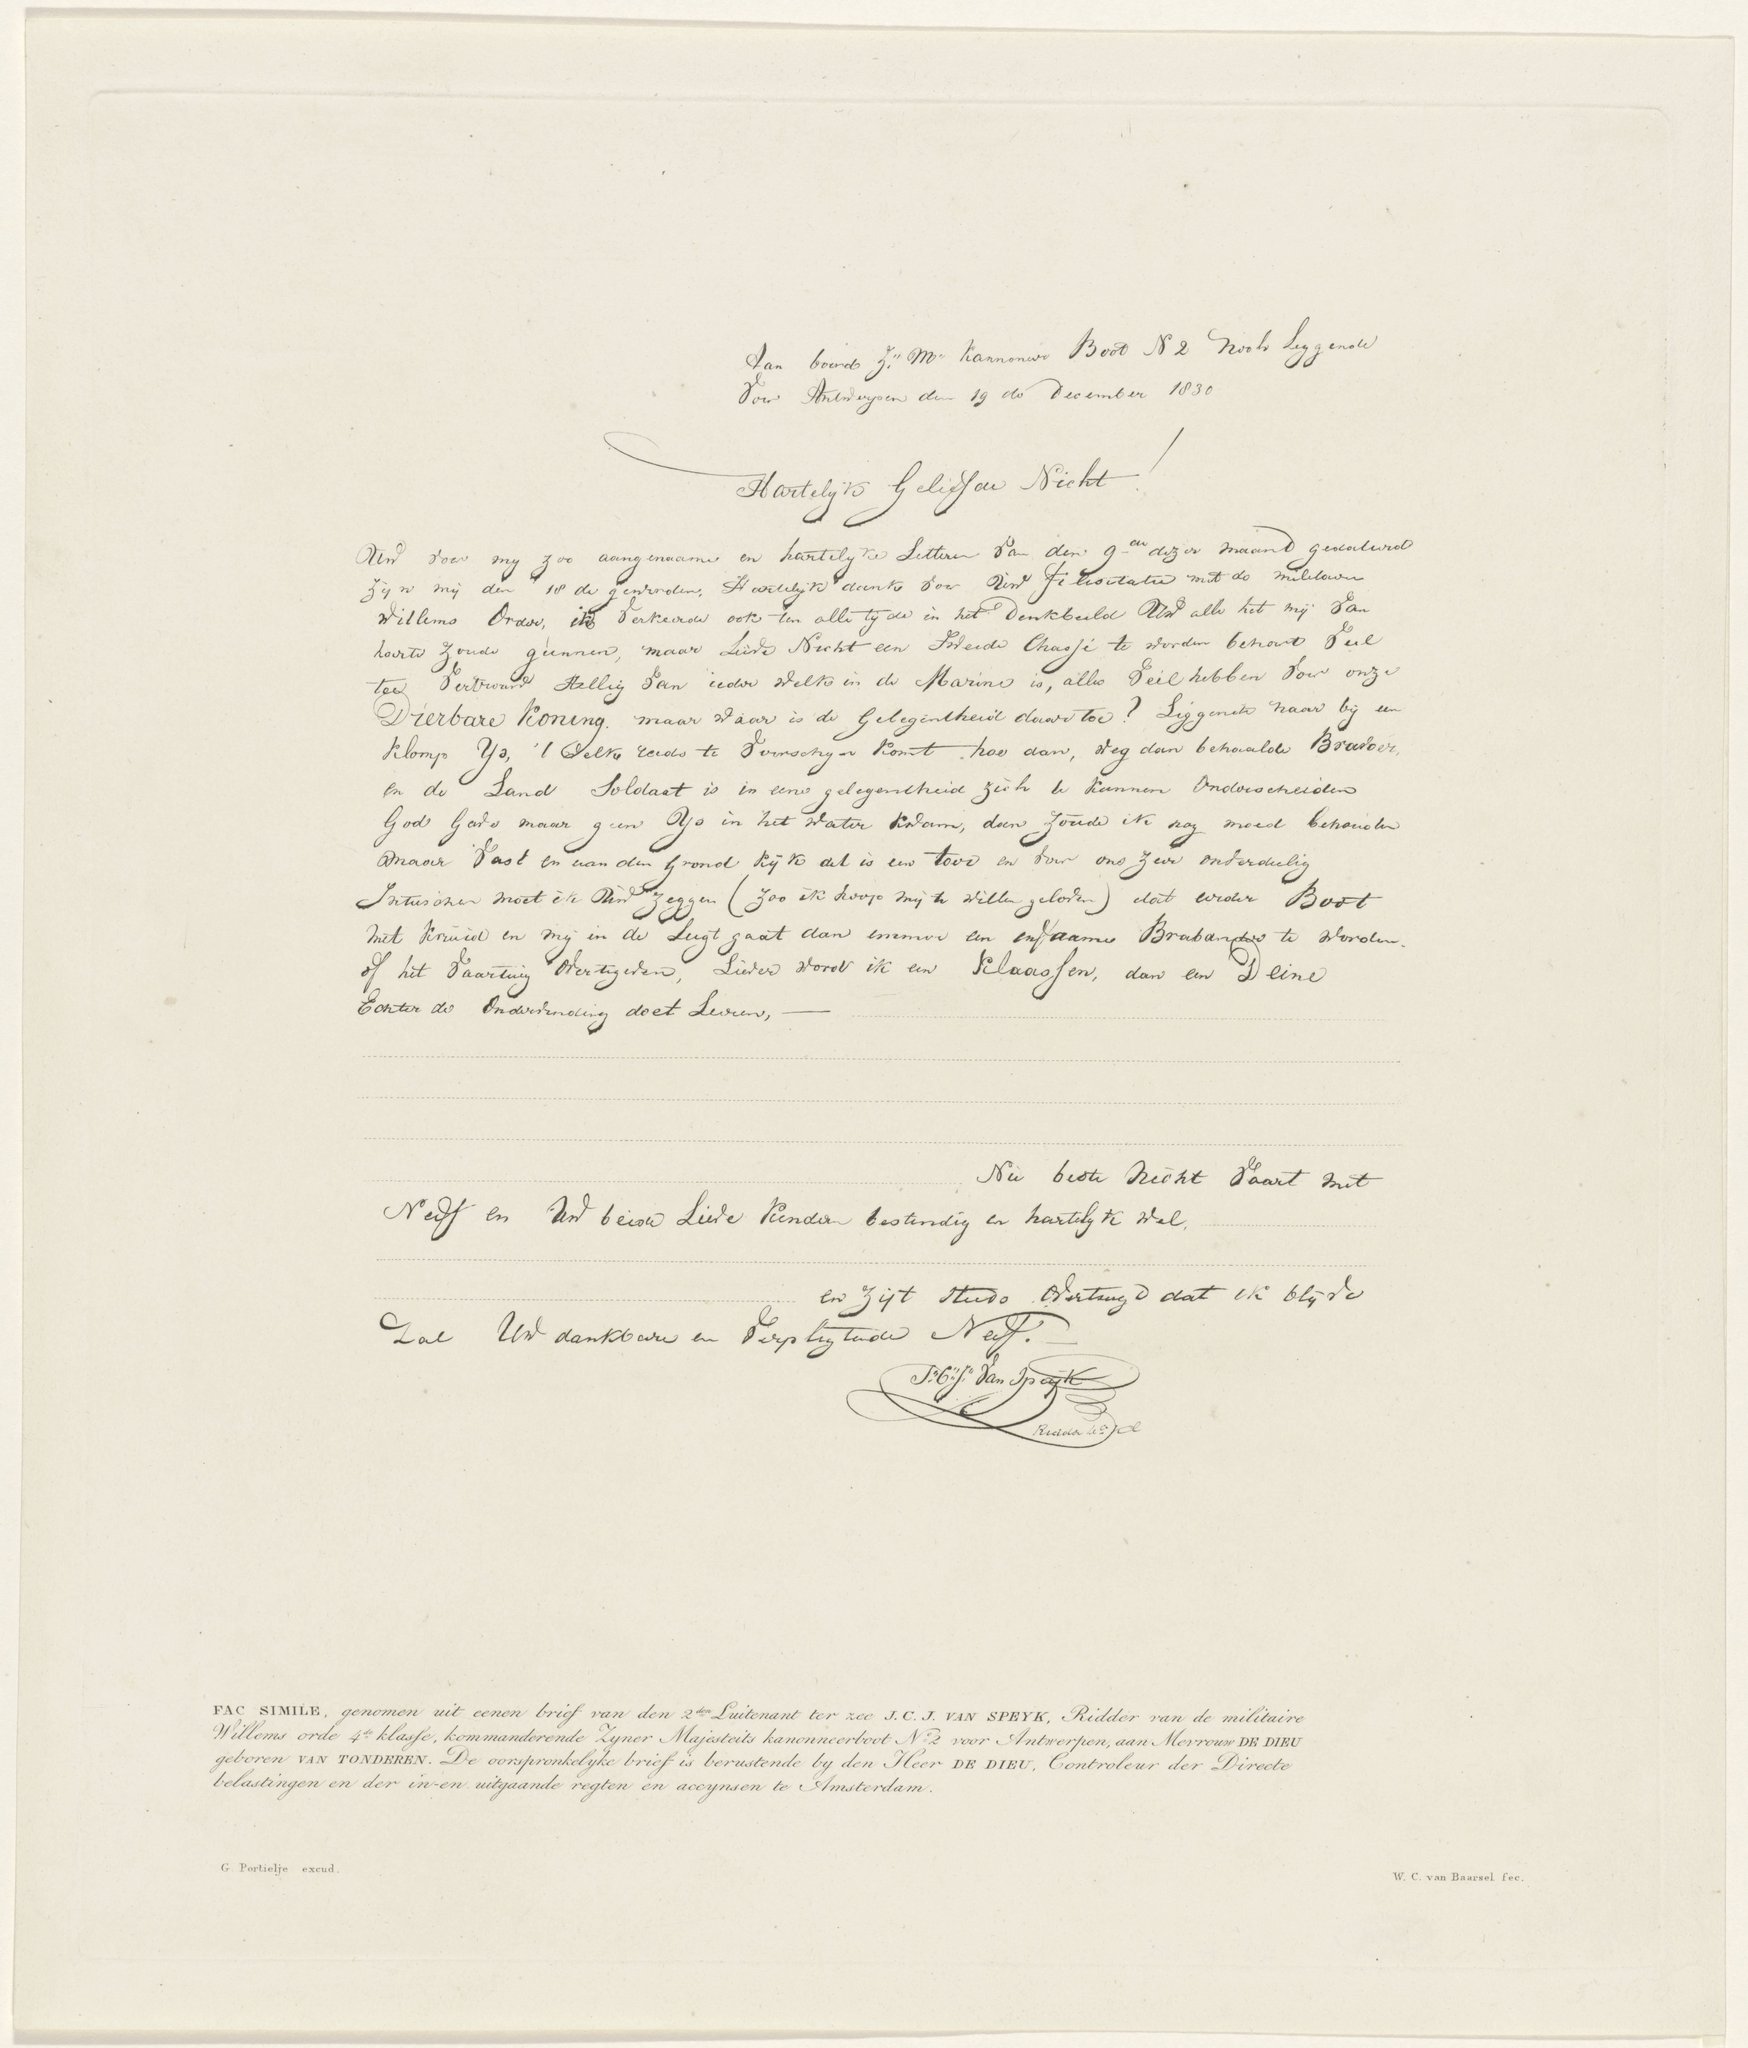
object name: print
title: Facsimile van een brief van Jan van Speyk aan zijn nicht mevr. de Dieu-van Tonderen, 1830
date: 1831-1832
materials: paper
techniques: etching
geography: netherlands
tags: antwerp, jan van speyk, letter, envelope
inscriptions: collector's mark: Lugt 2228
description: Facsimile van een brief van Jan van Speyk aan zijn nicht mevr. de Dieu-van Tonderen, geschreven aan boord van kanonneerboot nr. 2 liggende voor Antwerpen op 19 december 1830. In de brief schrijft hij dat hij liever een Reinier Claeszen is dan een Nicolas J. Daine.